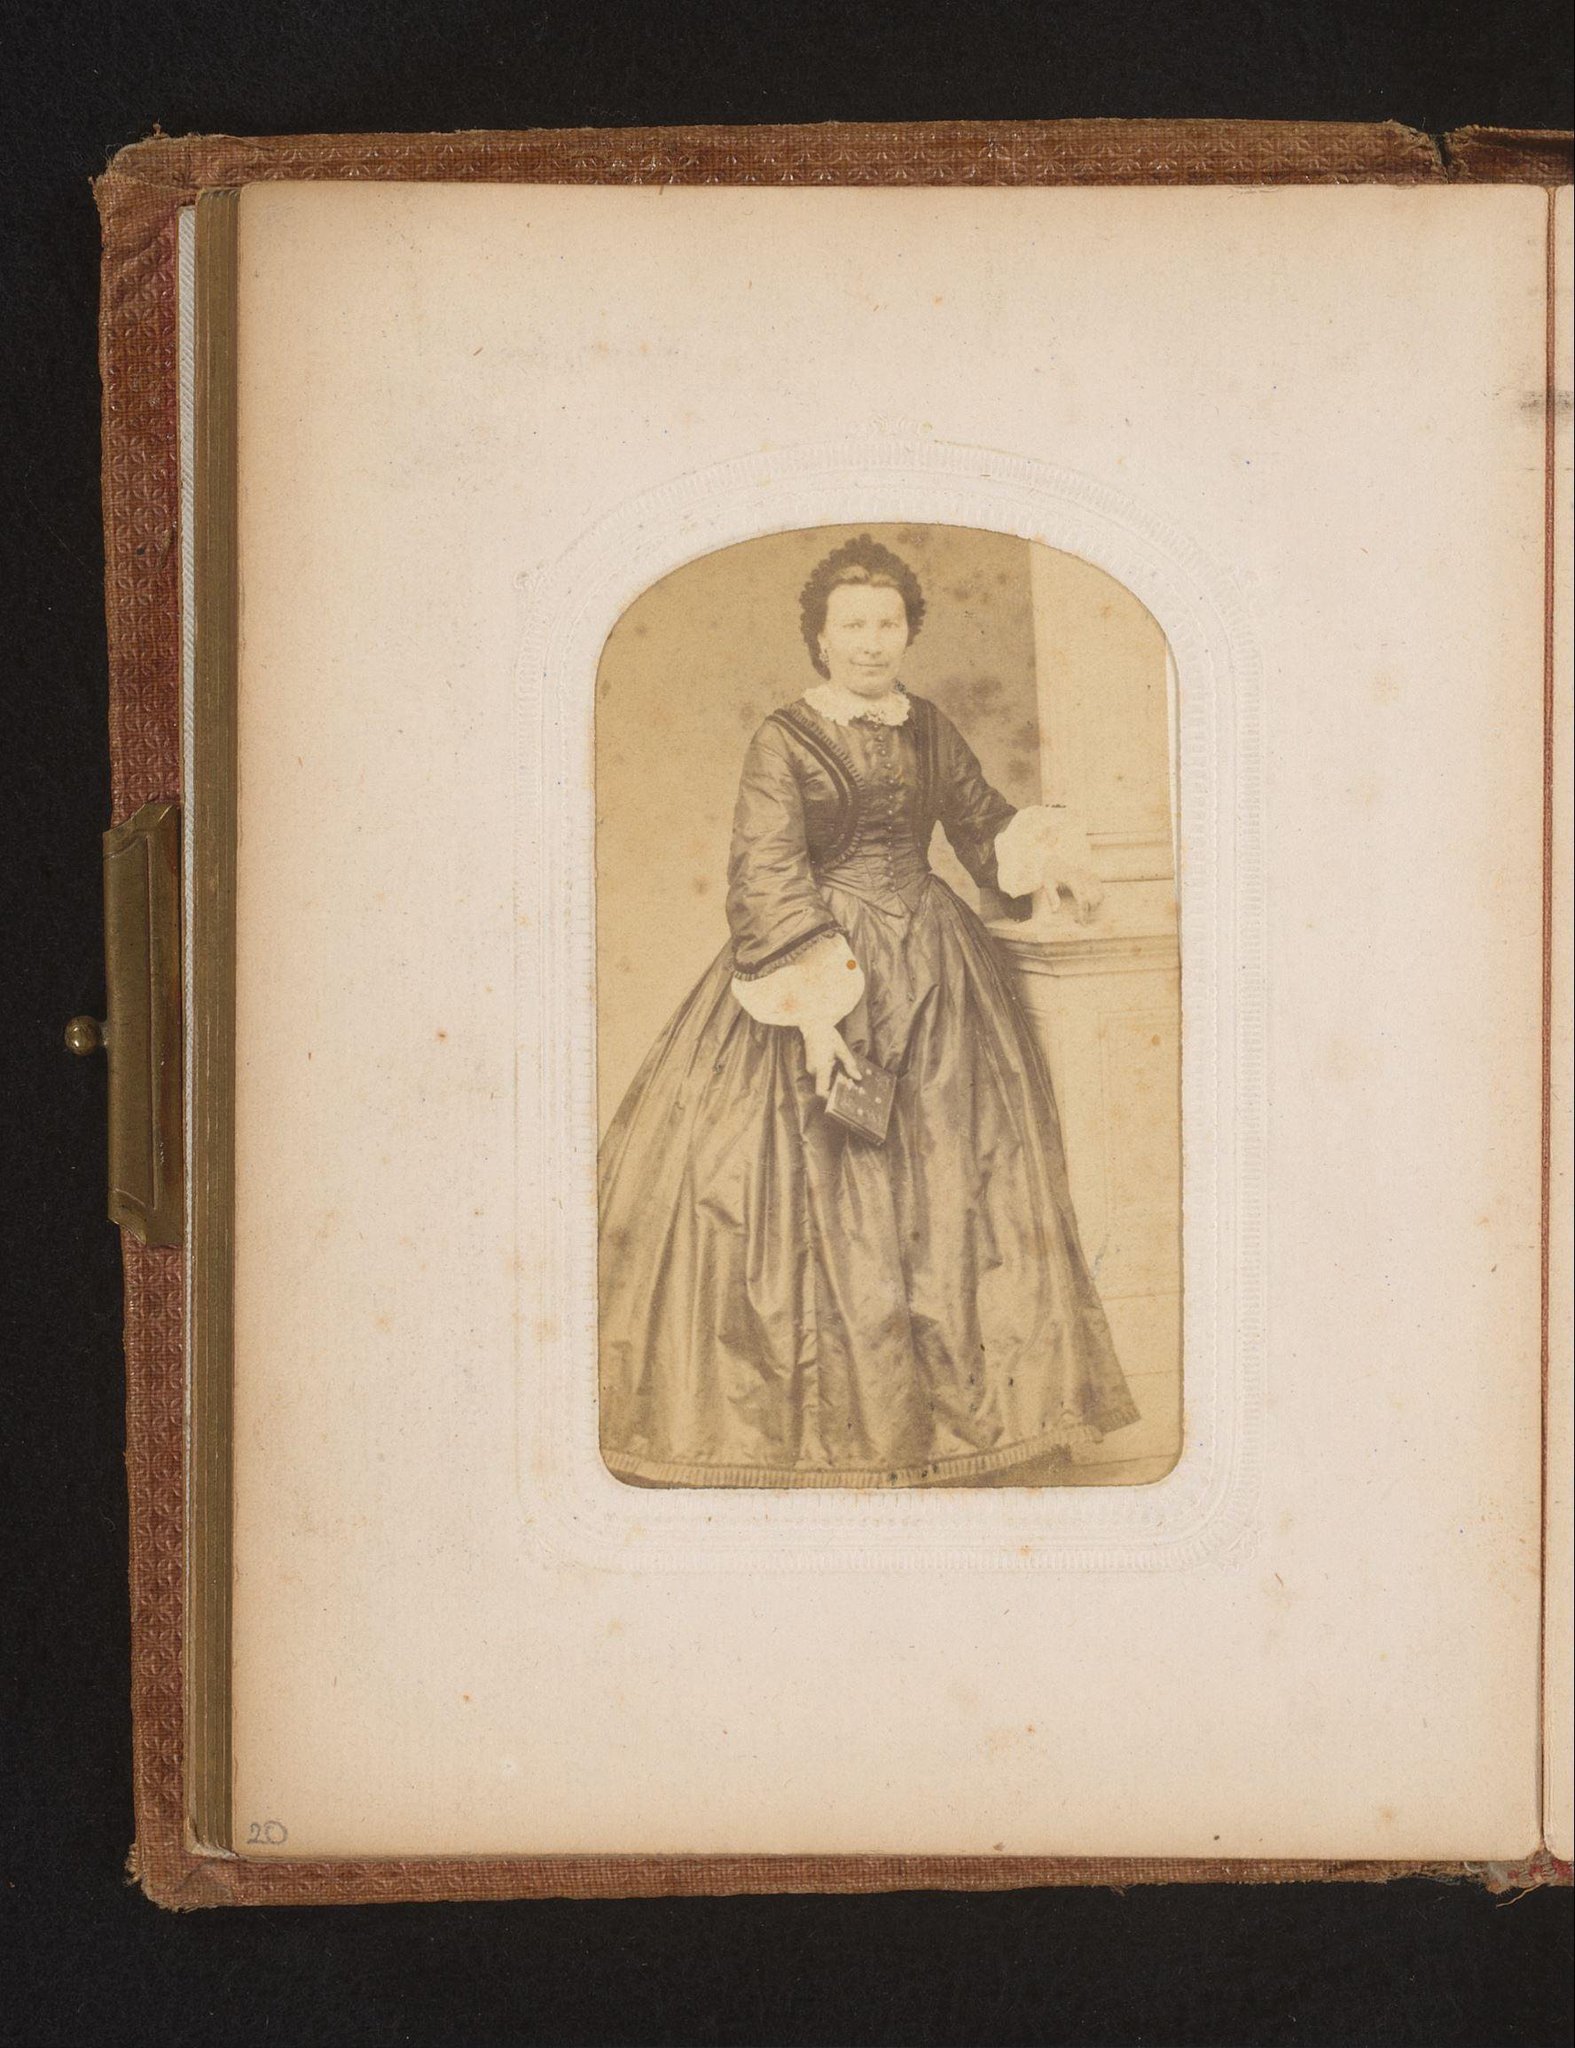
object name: carte de visite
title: Portret van een vrouw, staand bij een balustrade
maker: g.a. stamm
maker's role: fotograaf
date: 1860-1900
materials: cardboard, photographic support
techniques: albumen print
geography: frankfurt am main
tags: historical persons - bb - woman, balustrade, standing figure - aa - female human figure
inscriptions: inscription: ‘PHOTOGRAPHISCHES INSTITUT/ von/ G. A. Stamm/ FRANKFURT a/M./ Die Original-Platte ist zum Nachbestellen/ aufbewahrt.’